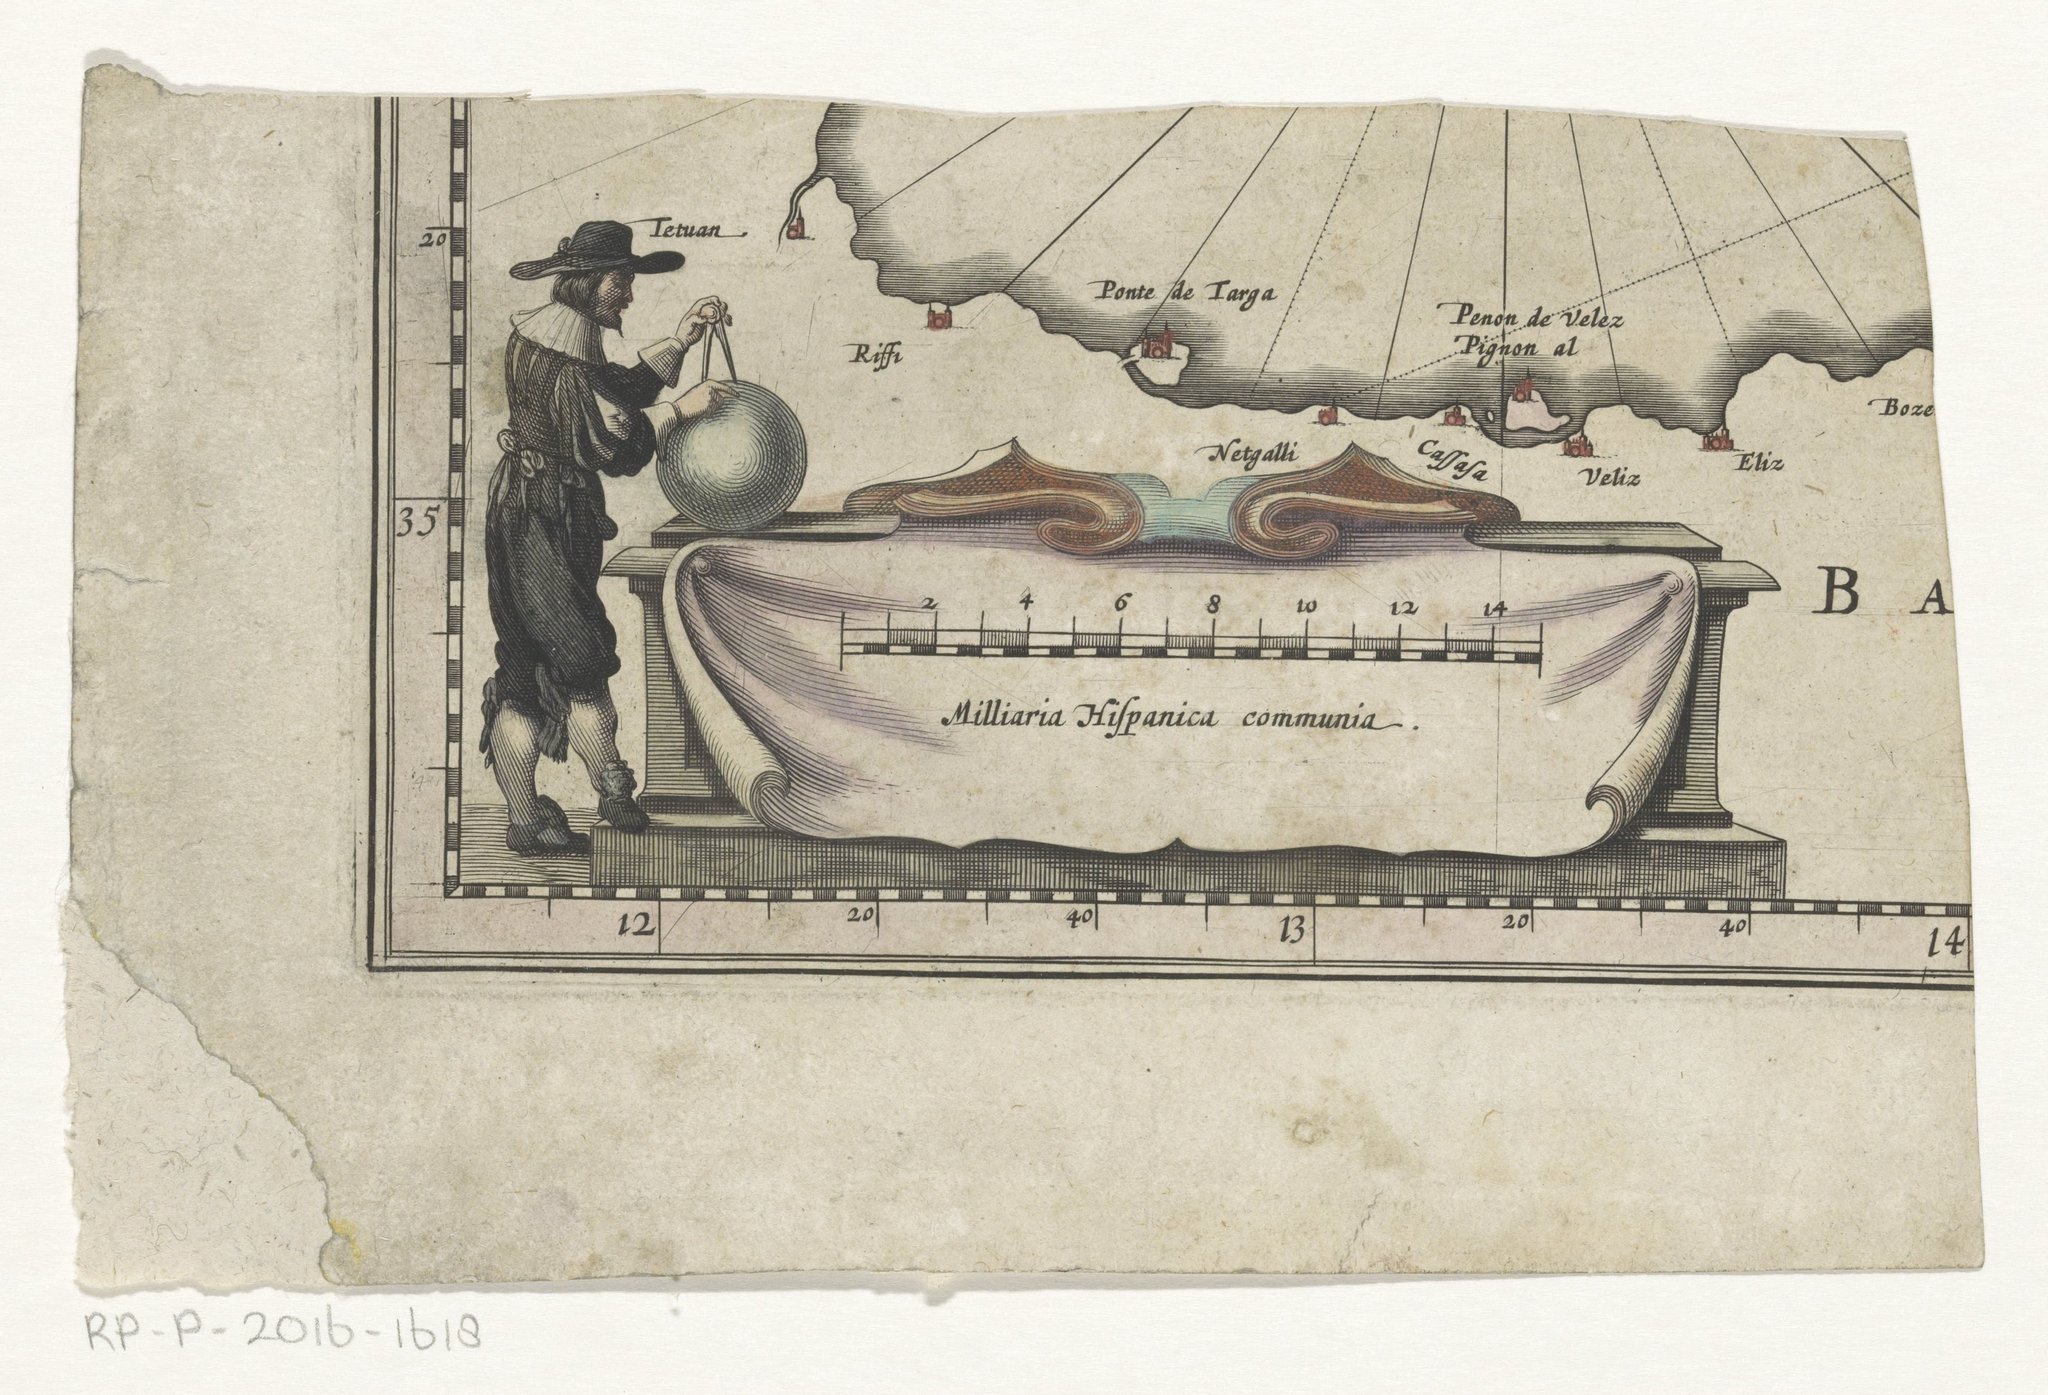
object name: print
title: Schaalverdeling met man met globe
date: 1634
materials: paper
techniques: engraving, hand coloring, letterpress printing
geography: netherlands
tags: measuring-instruments, globe, scales of notation (arithmetic), spain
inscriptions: collector's mark: Lugt 2228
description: Een man met globe en passer staat naast een schaalverdeling. Detail van een kaart van Zuid-Spanje met de steden Granada en Murcia.